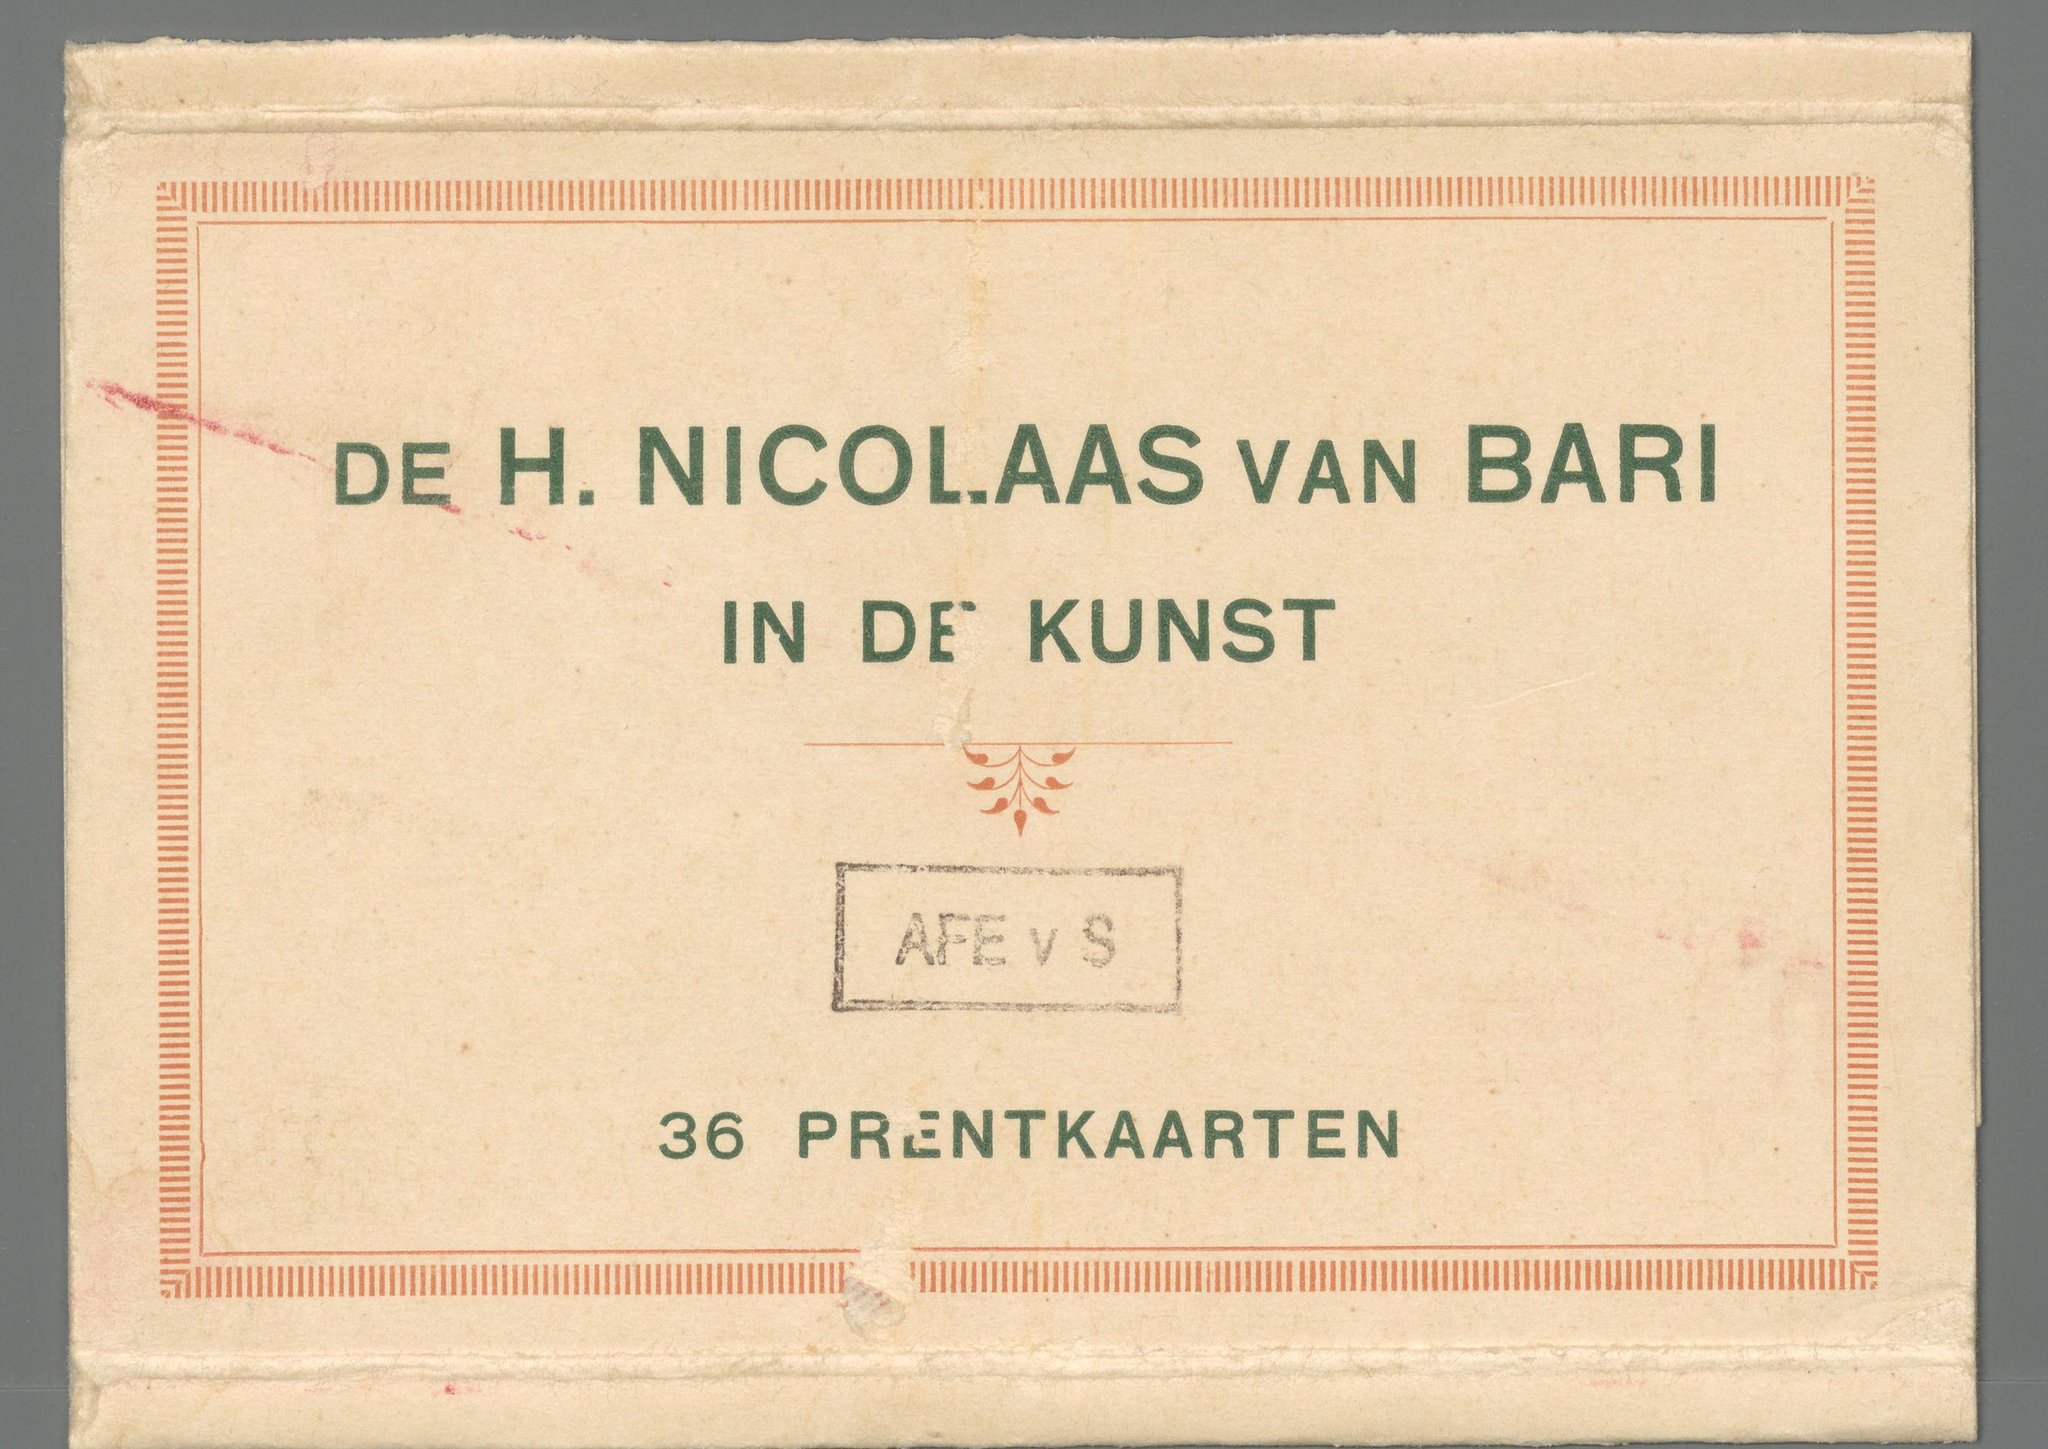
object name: wrapper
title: De H. Nicolaas van Bari in de kunst. 36 prentbriefkaarten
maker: Anonymous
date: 1928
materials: cardboard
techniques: printing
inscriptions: collector's mark: ‘AFE v S’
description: Het omslag is bedoeld voor 36 prentbriefkaarten. In dit exemplaar zijn 32 prentbriefkaarten aangetroffen. In de omslag zit een tekst ingestoken met daarop een beschrijving van het leven van H. Nicolaas van Bari en een overzicht van de prentbriefkaarten.